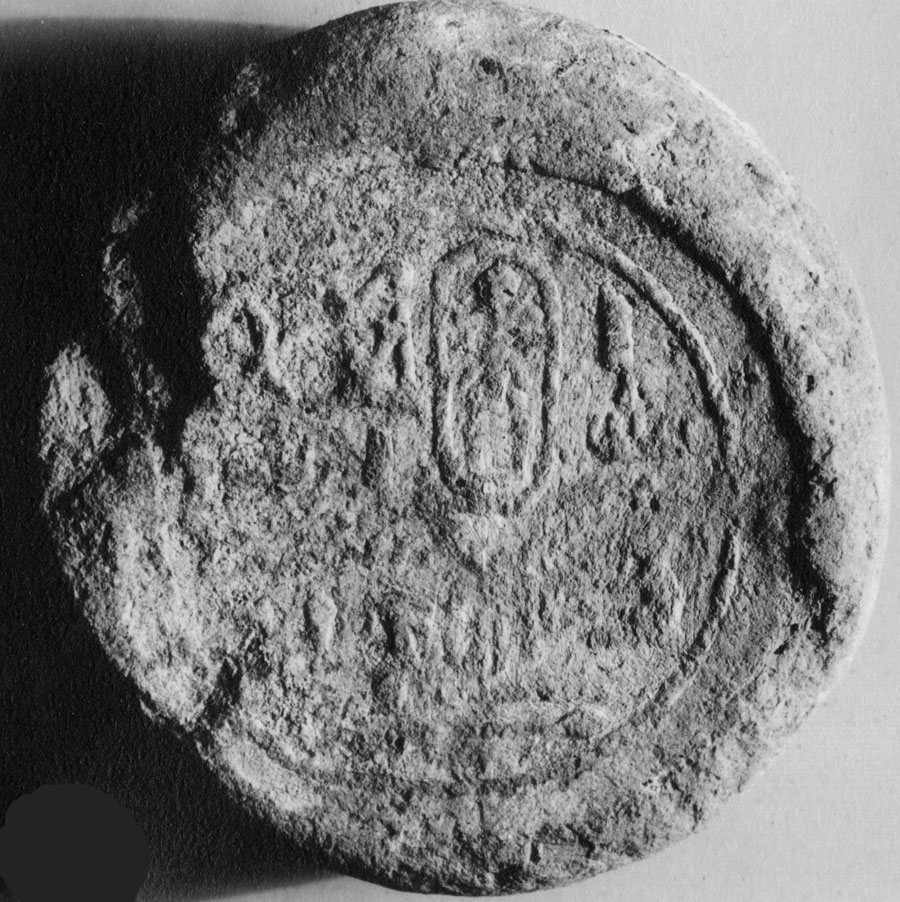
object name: cone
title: Funerary Cone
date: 1550-1295 BCE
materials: pottery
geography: egypt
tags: hieroglyphs